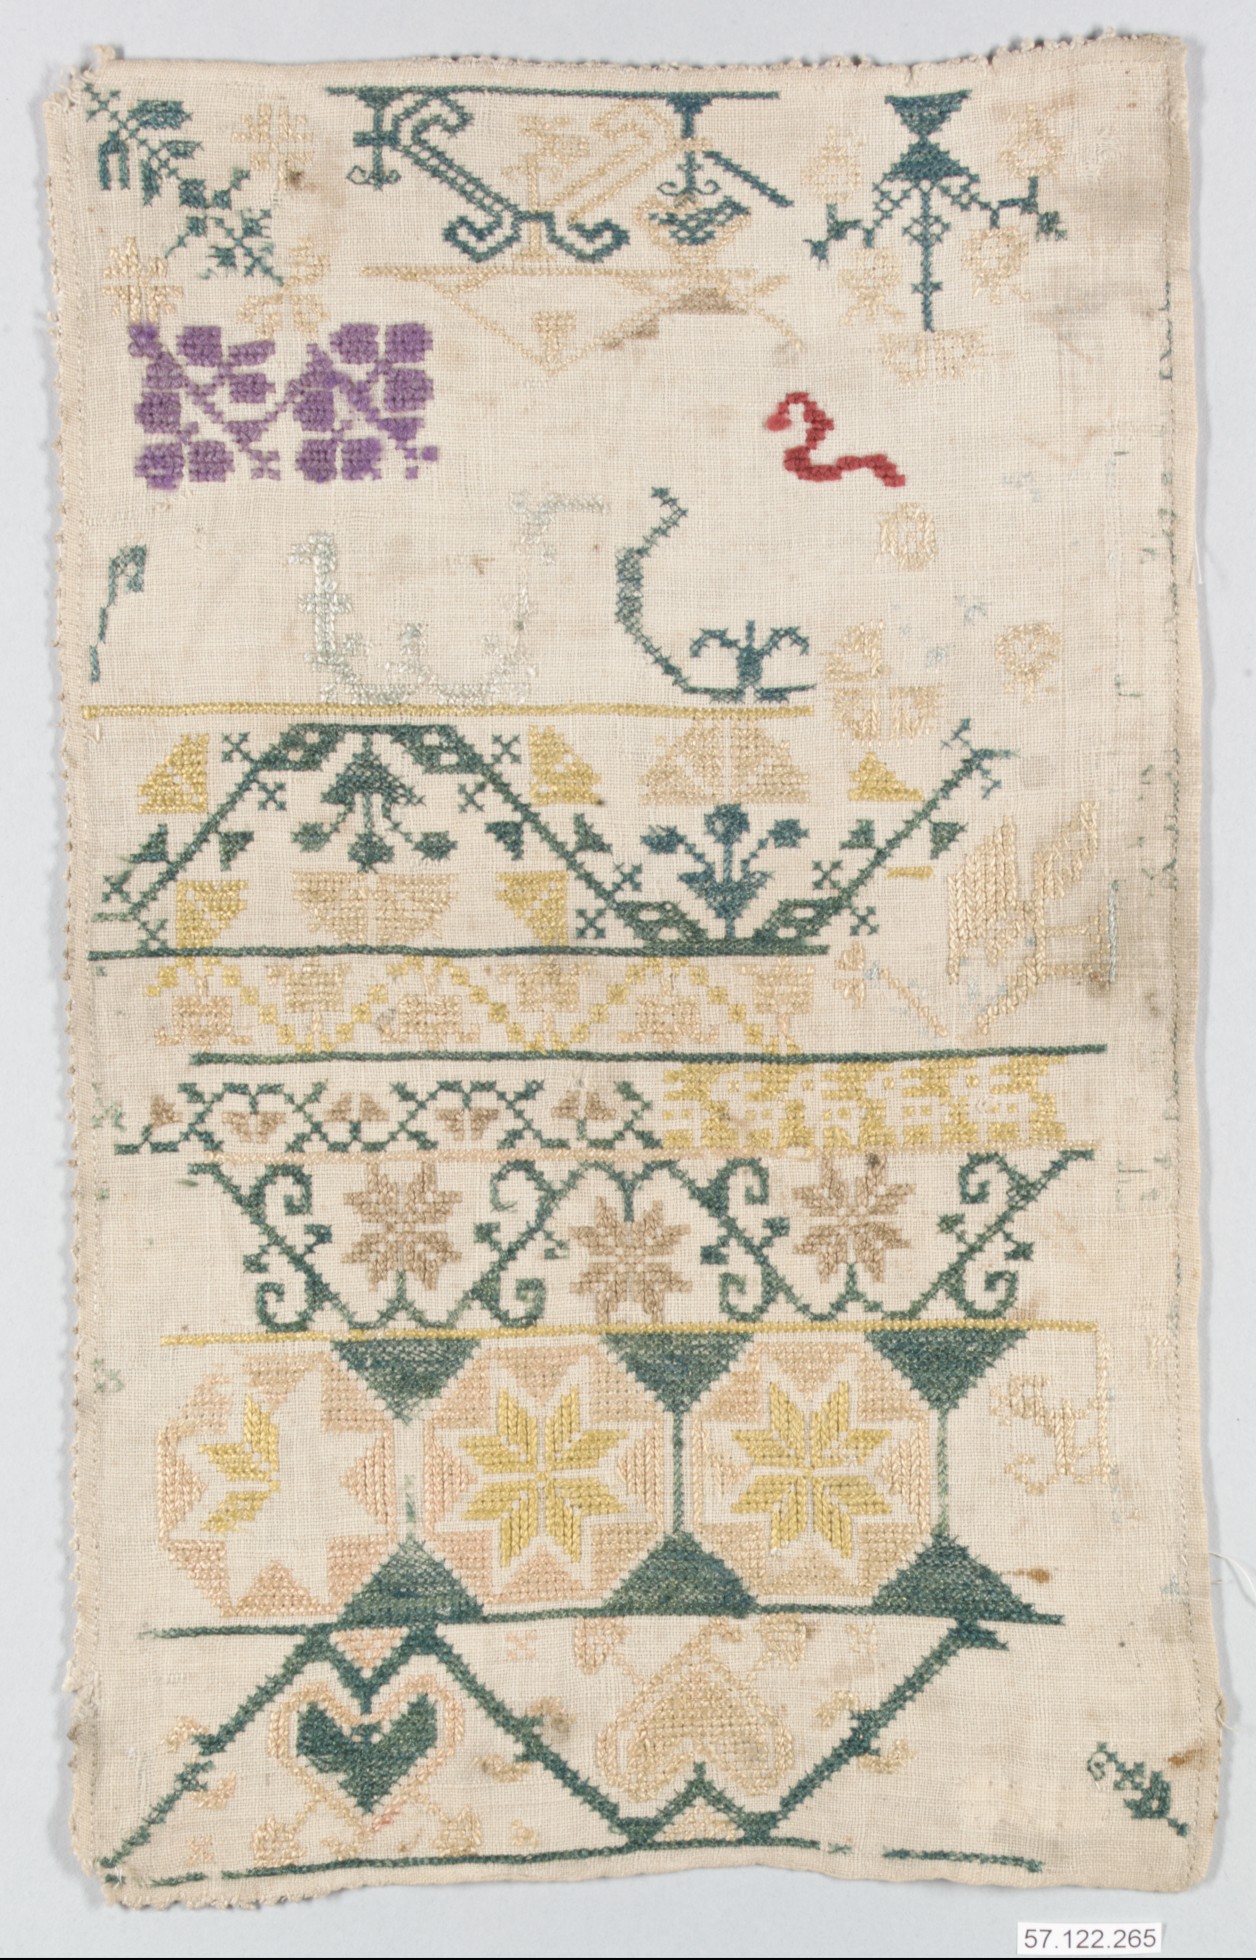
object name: sampler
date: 1801-1900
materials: cotton, wool